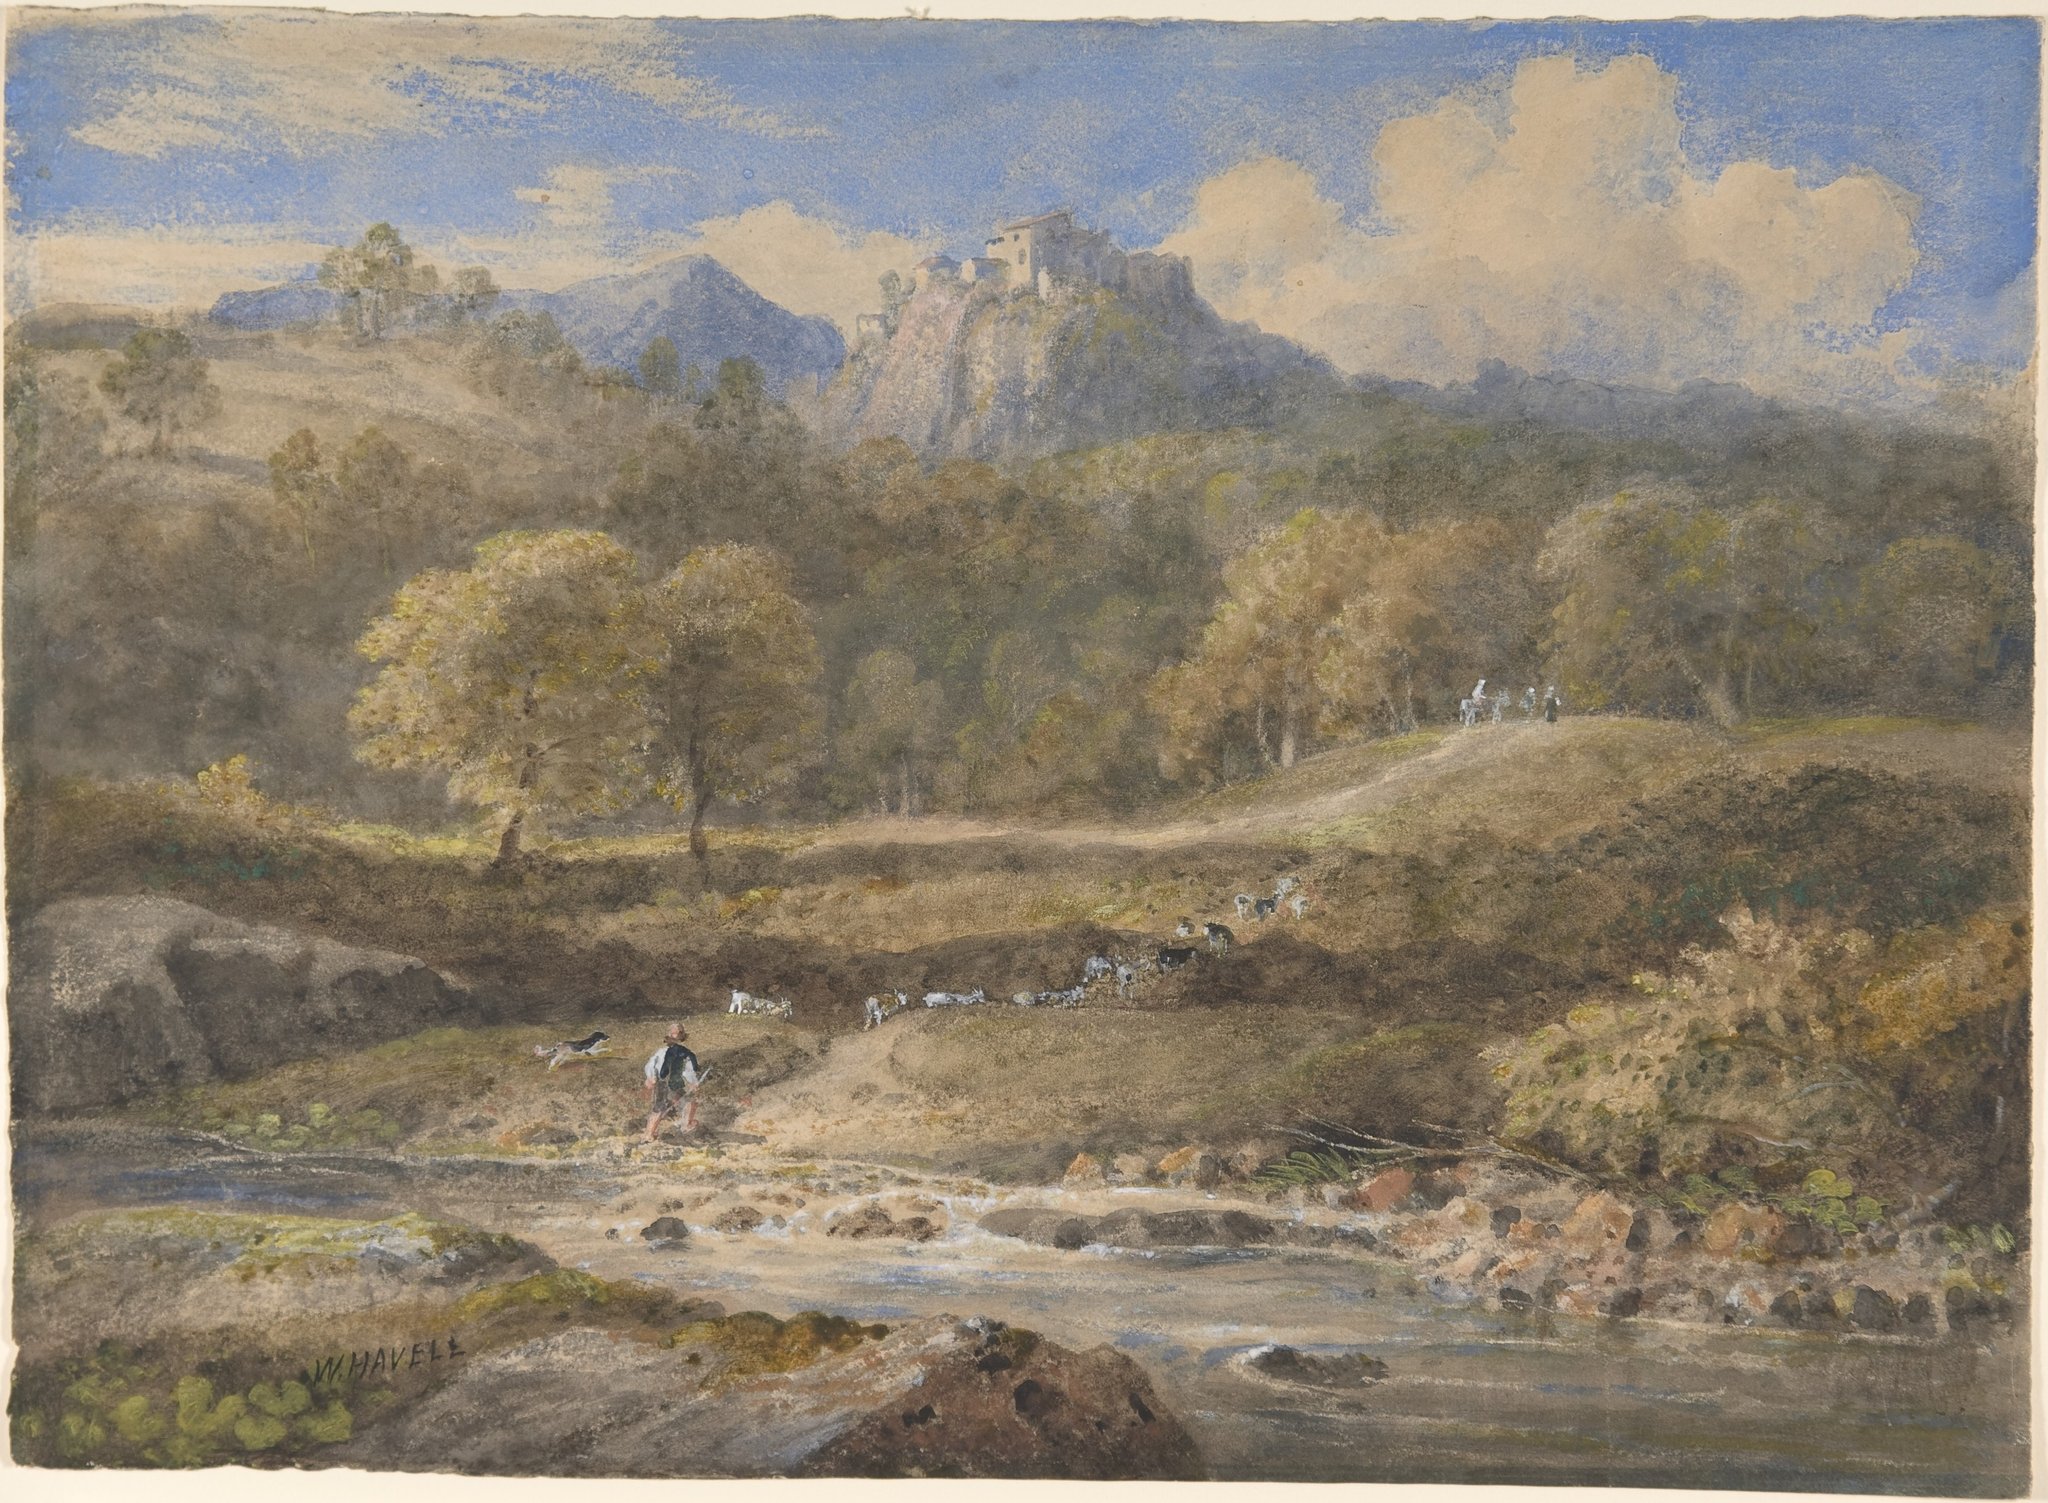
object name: drawing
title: Licenza, near Rome: Horace's Villa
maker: william havell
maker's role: artist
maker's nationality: british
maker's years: 1782-1857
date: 1828-1829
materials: gouache, graphite, watercolor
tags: buildings,men,dogs,landscapes,rome